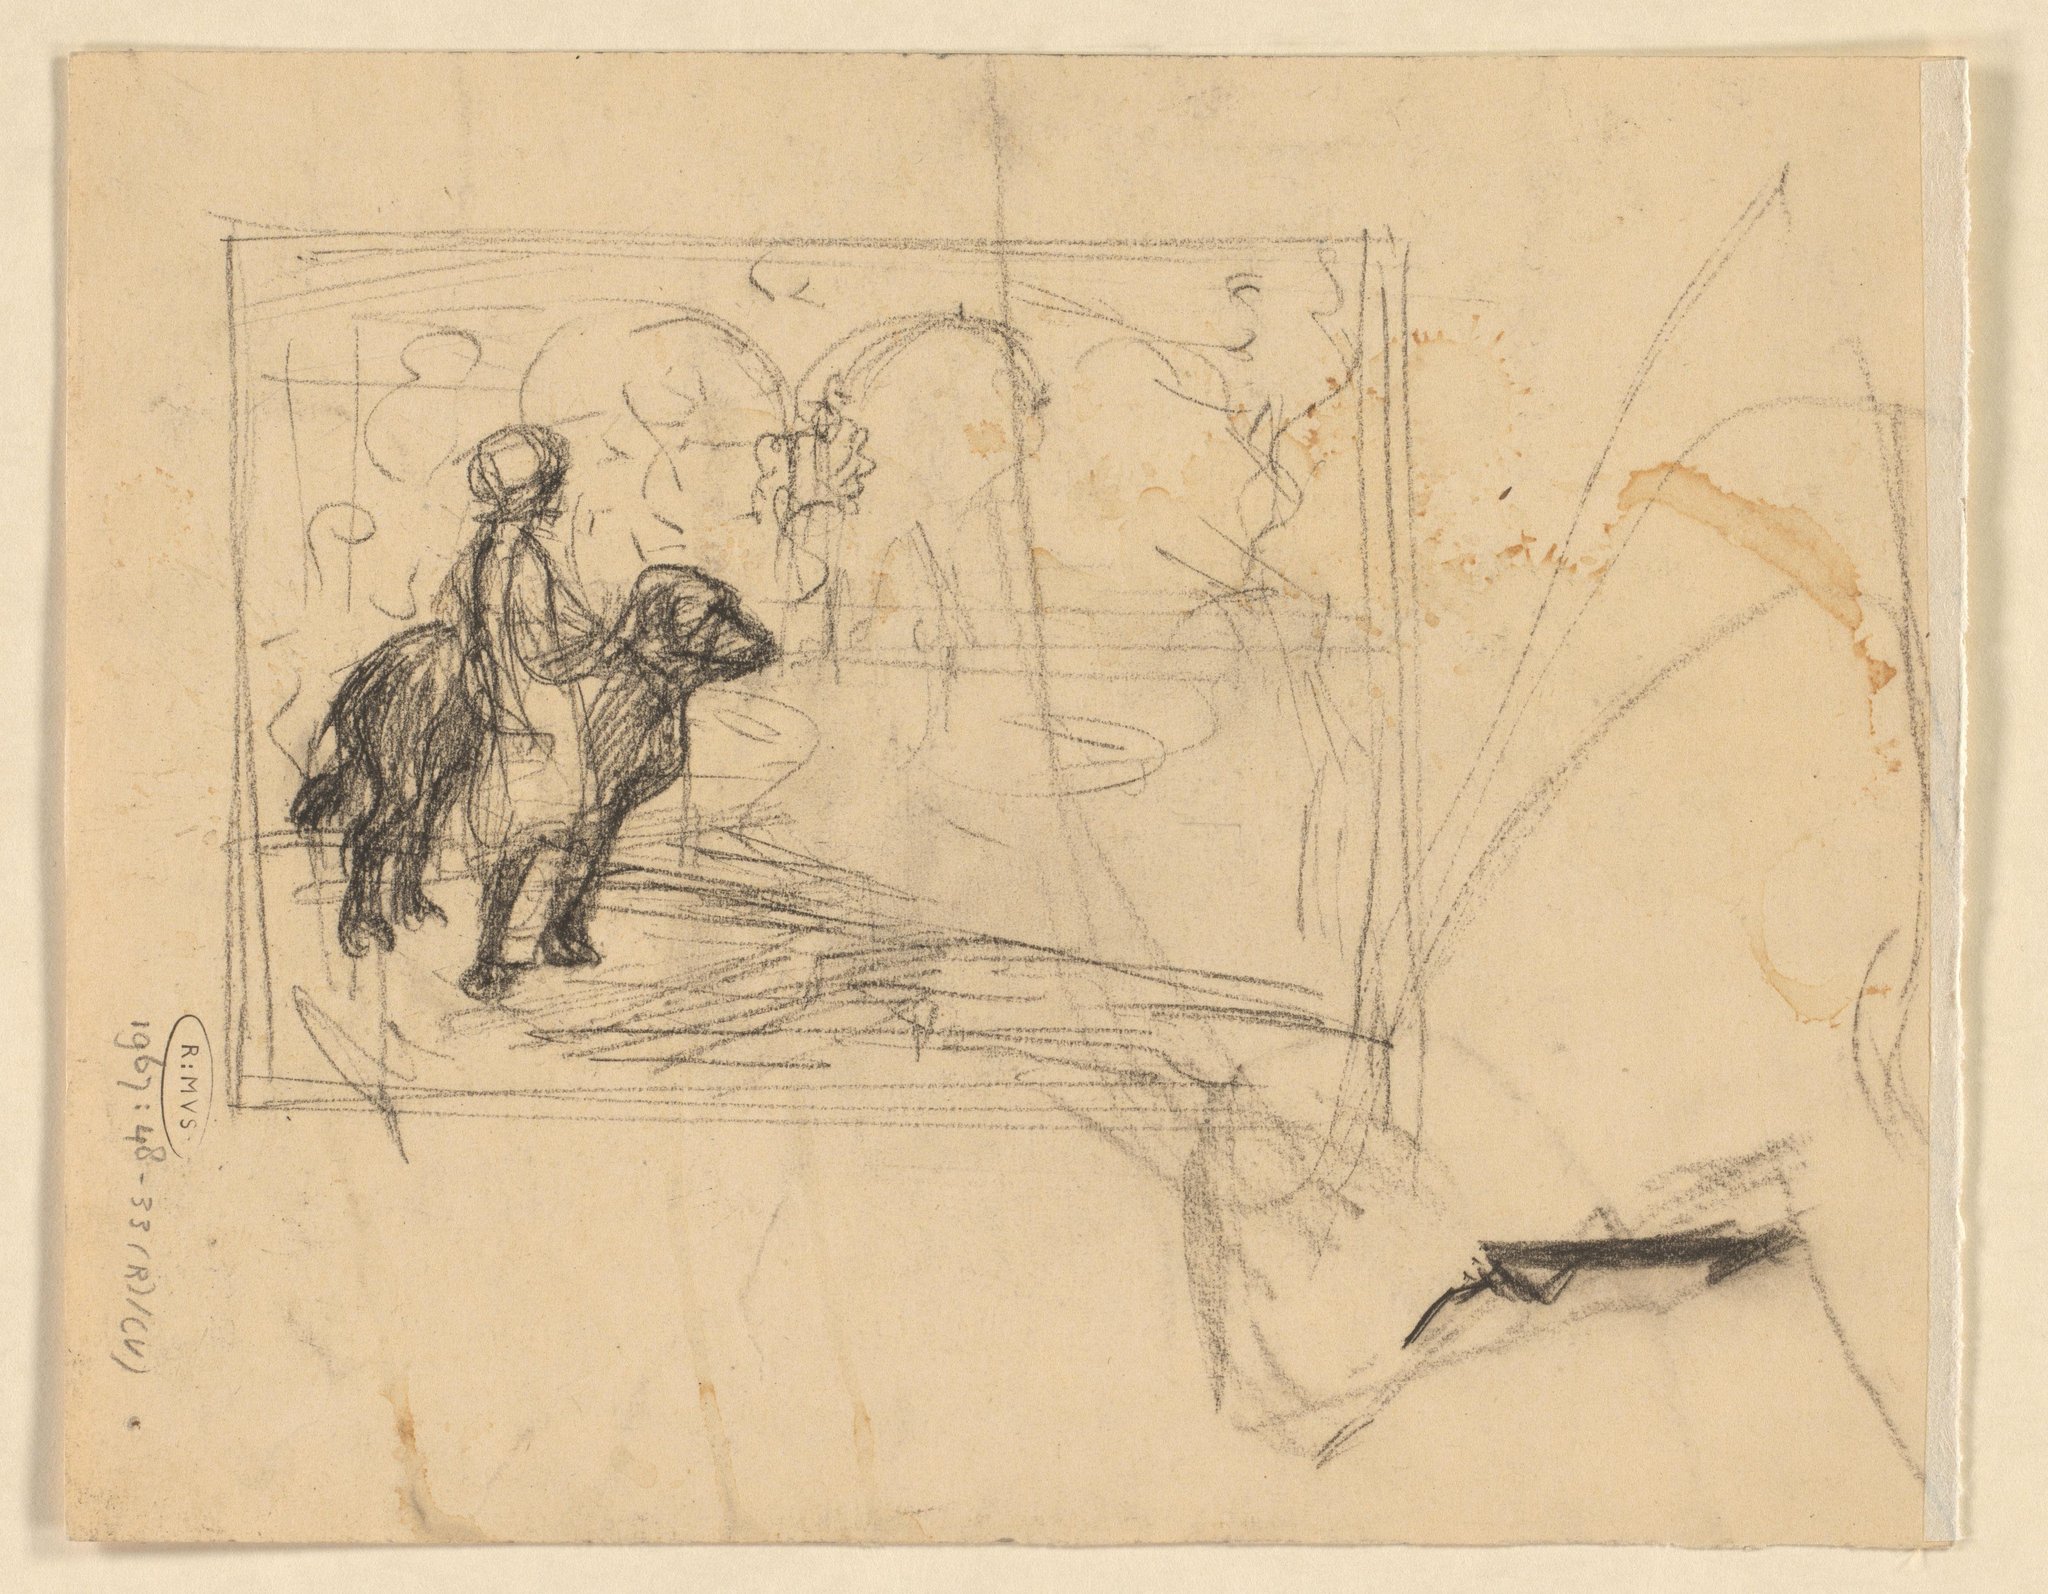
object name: boekillustratie ontwerp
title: Ella met een hond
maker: edzard koning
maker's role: draughtsman, print maker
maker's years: 1869-1954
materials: chalk, paper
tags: (snellen, ella in het feeënrijk) specific works of literature (with author, title), child (at home) - aa - girl, dog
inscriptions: collector's mark: Lugt 2228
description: Ontwerp voor: Snellen, Agatha. Ella in het Feeënrijk. Amsterdam: C.A.J. van Dishoeck, 1902.